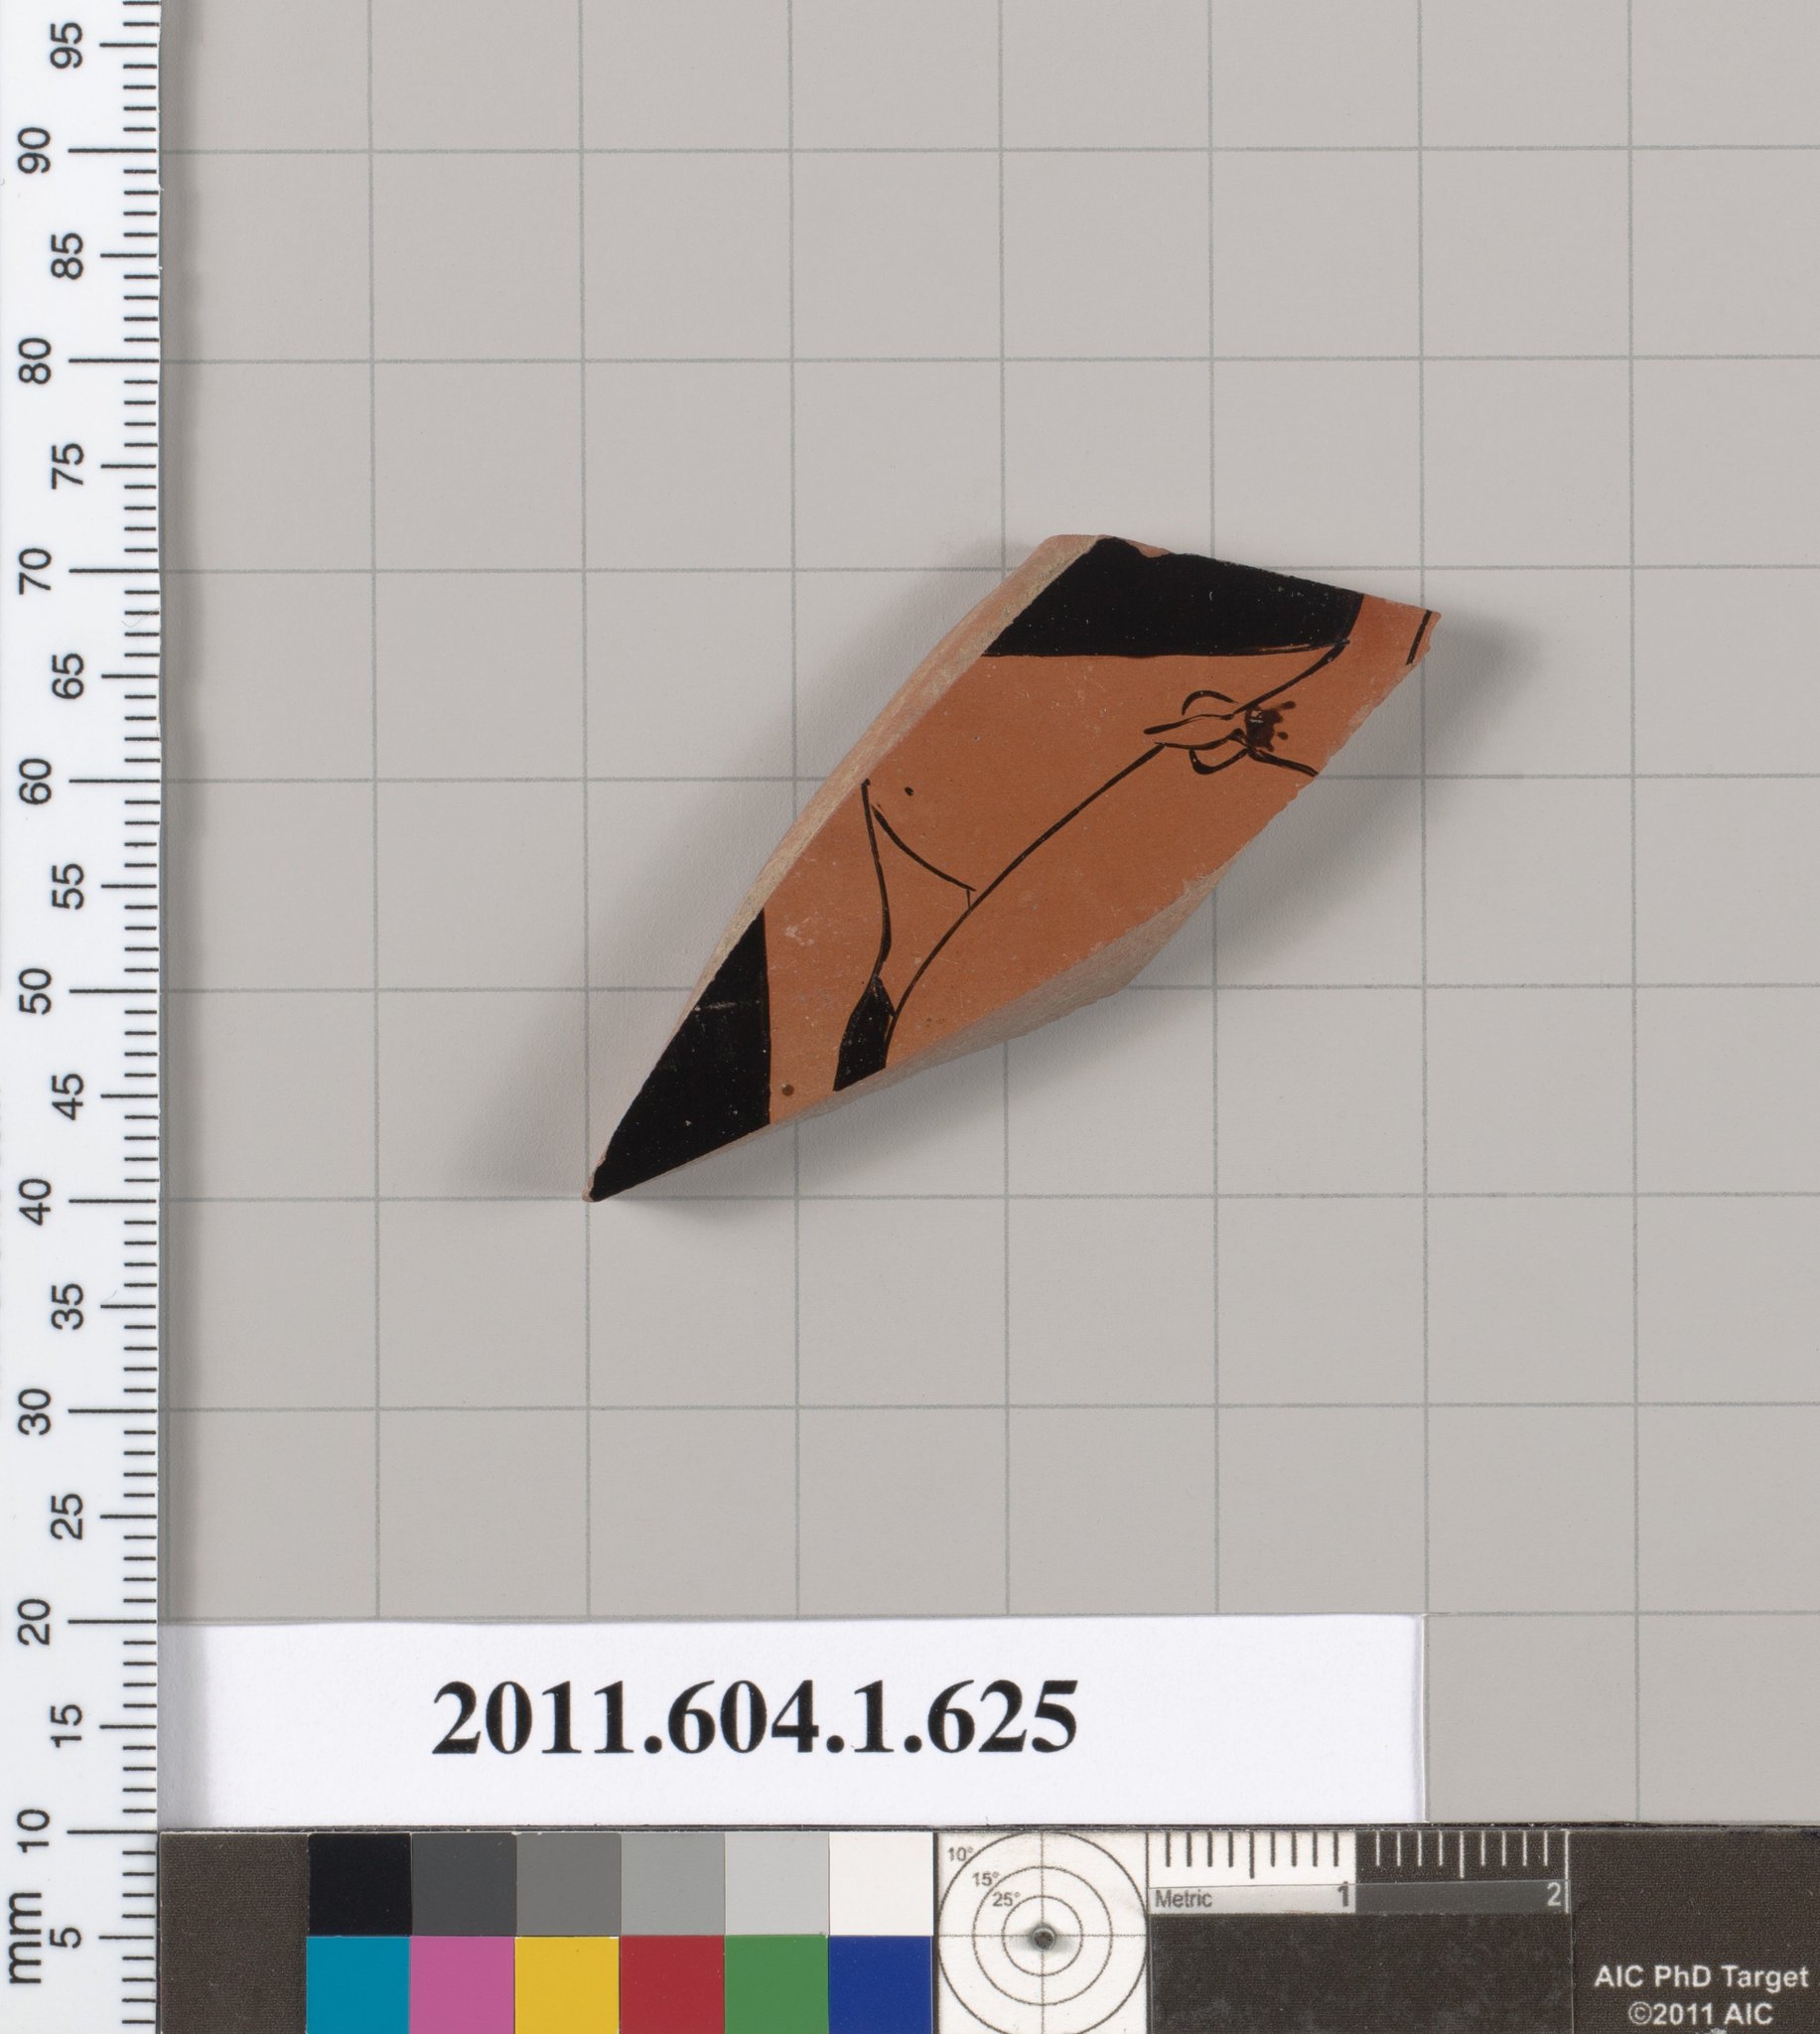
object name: kylix fragment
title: Terracotta fragment of a kylix (drinking cup)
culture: greek, attic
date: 475-451 BCE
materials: terracotta